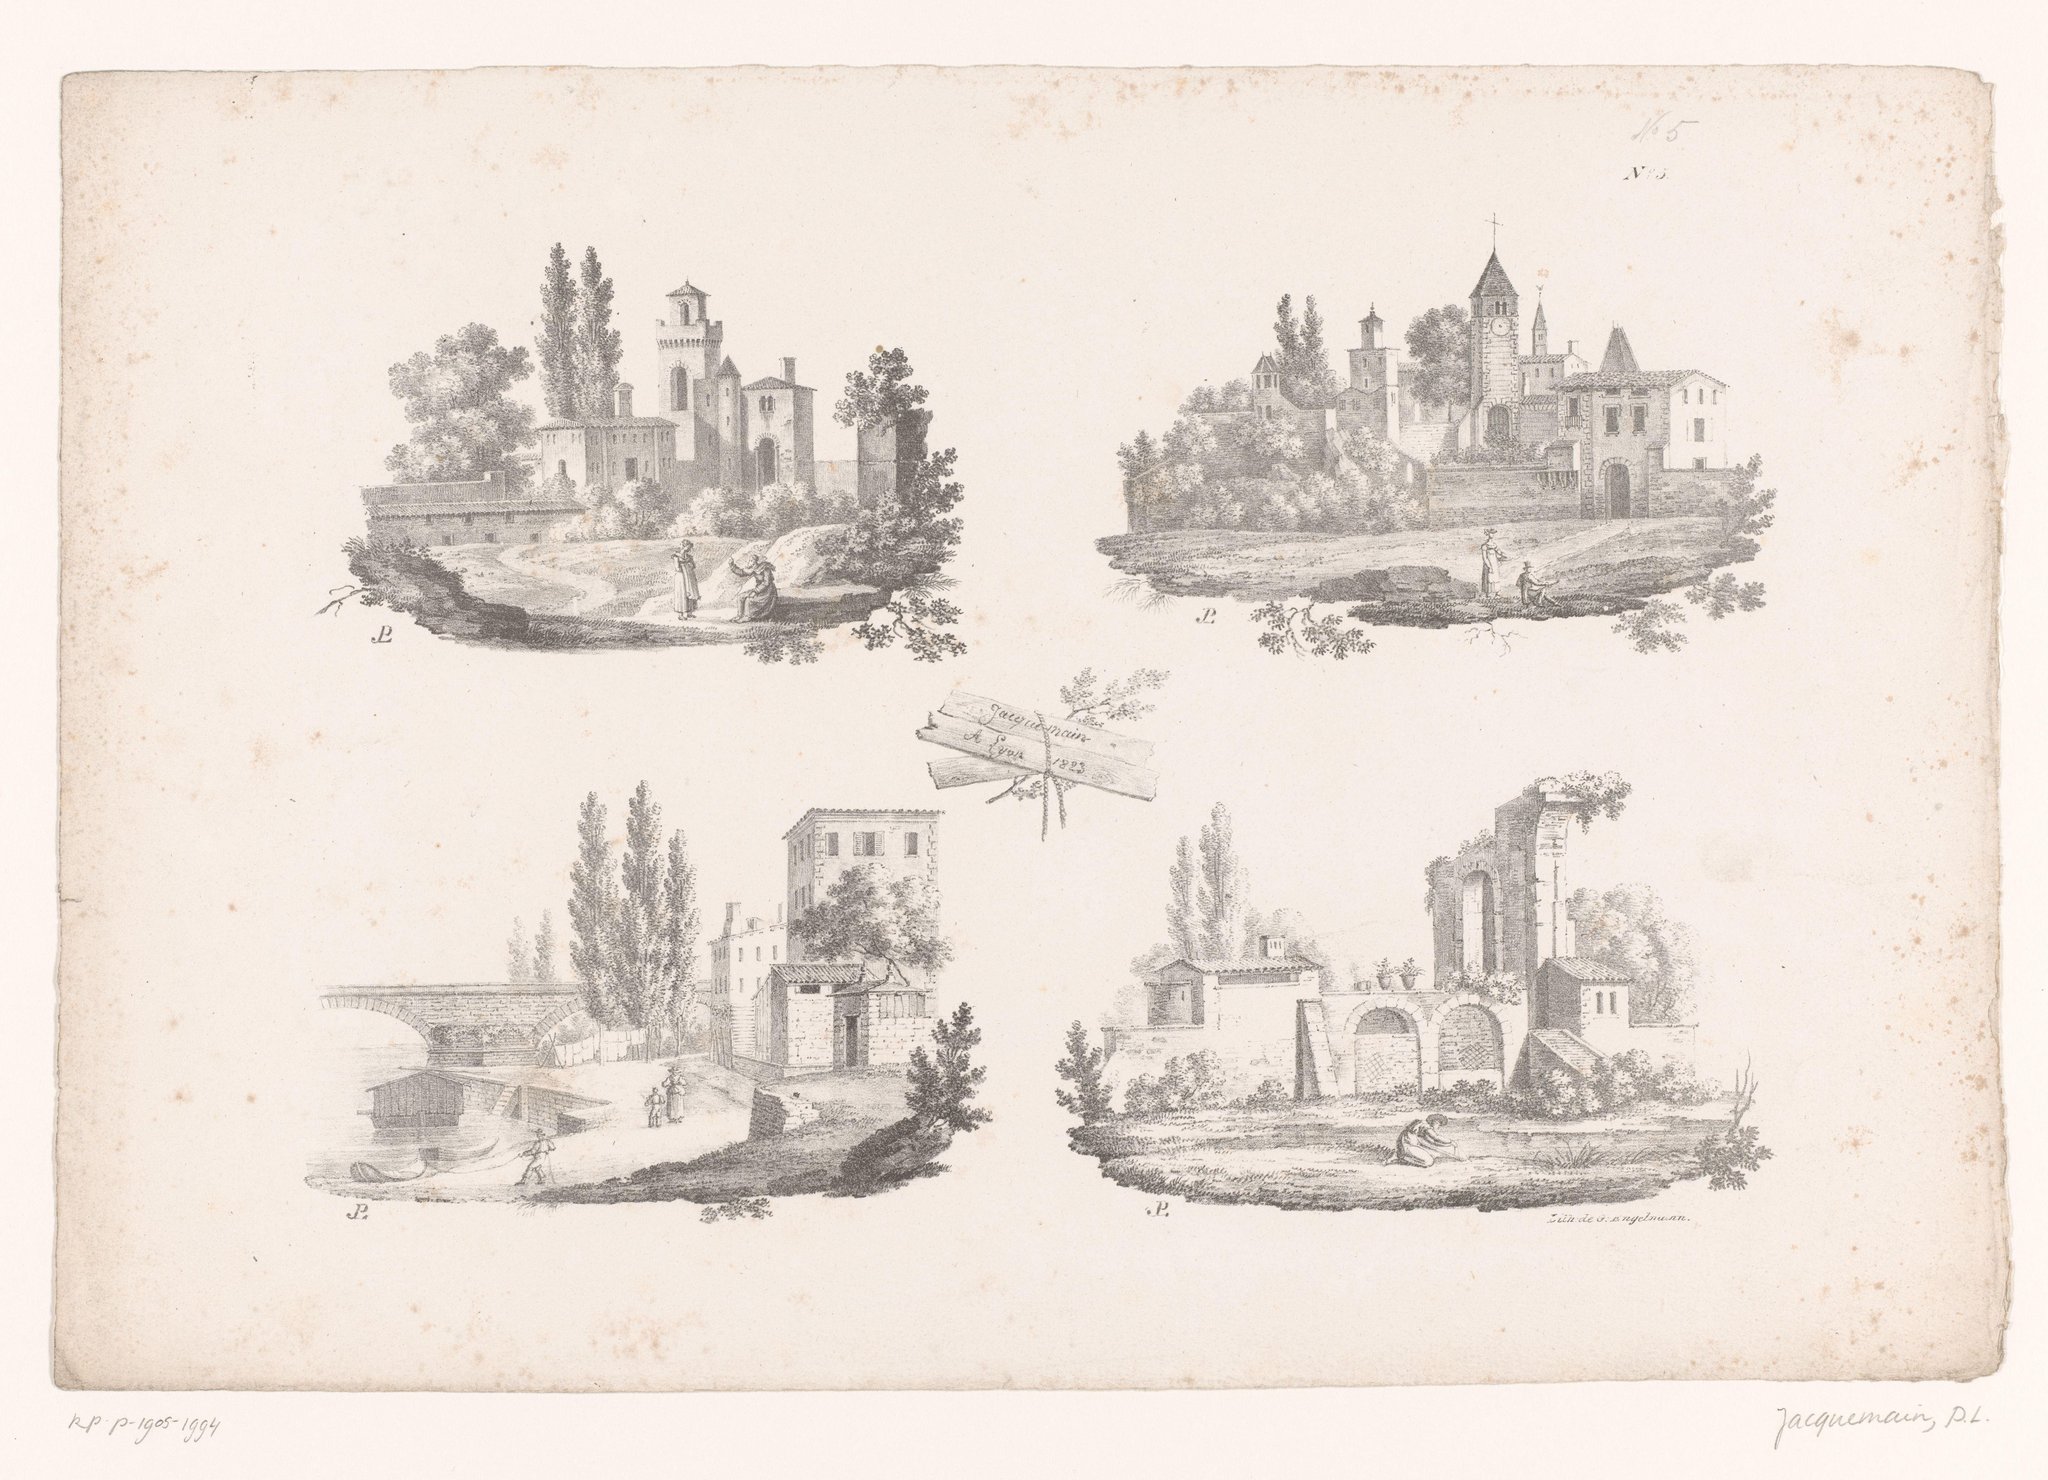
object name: print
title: Vier voorstellingen van stadspoorten, gebouwen en ruïnes in een landschap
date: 1823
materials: paper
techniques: lithograph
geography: lyon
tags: ruin of a building ~ architecture, village-gate (+ city(-scape) with figures, staffage), quay (+ city(-scape) with figures, staffage)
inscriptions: collector's mark: Lugt 2228a